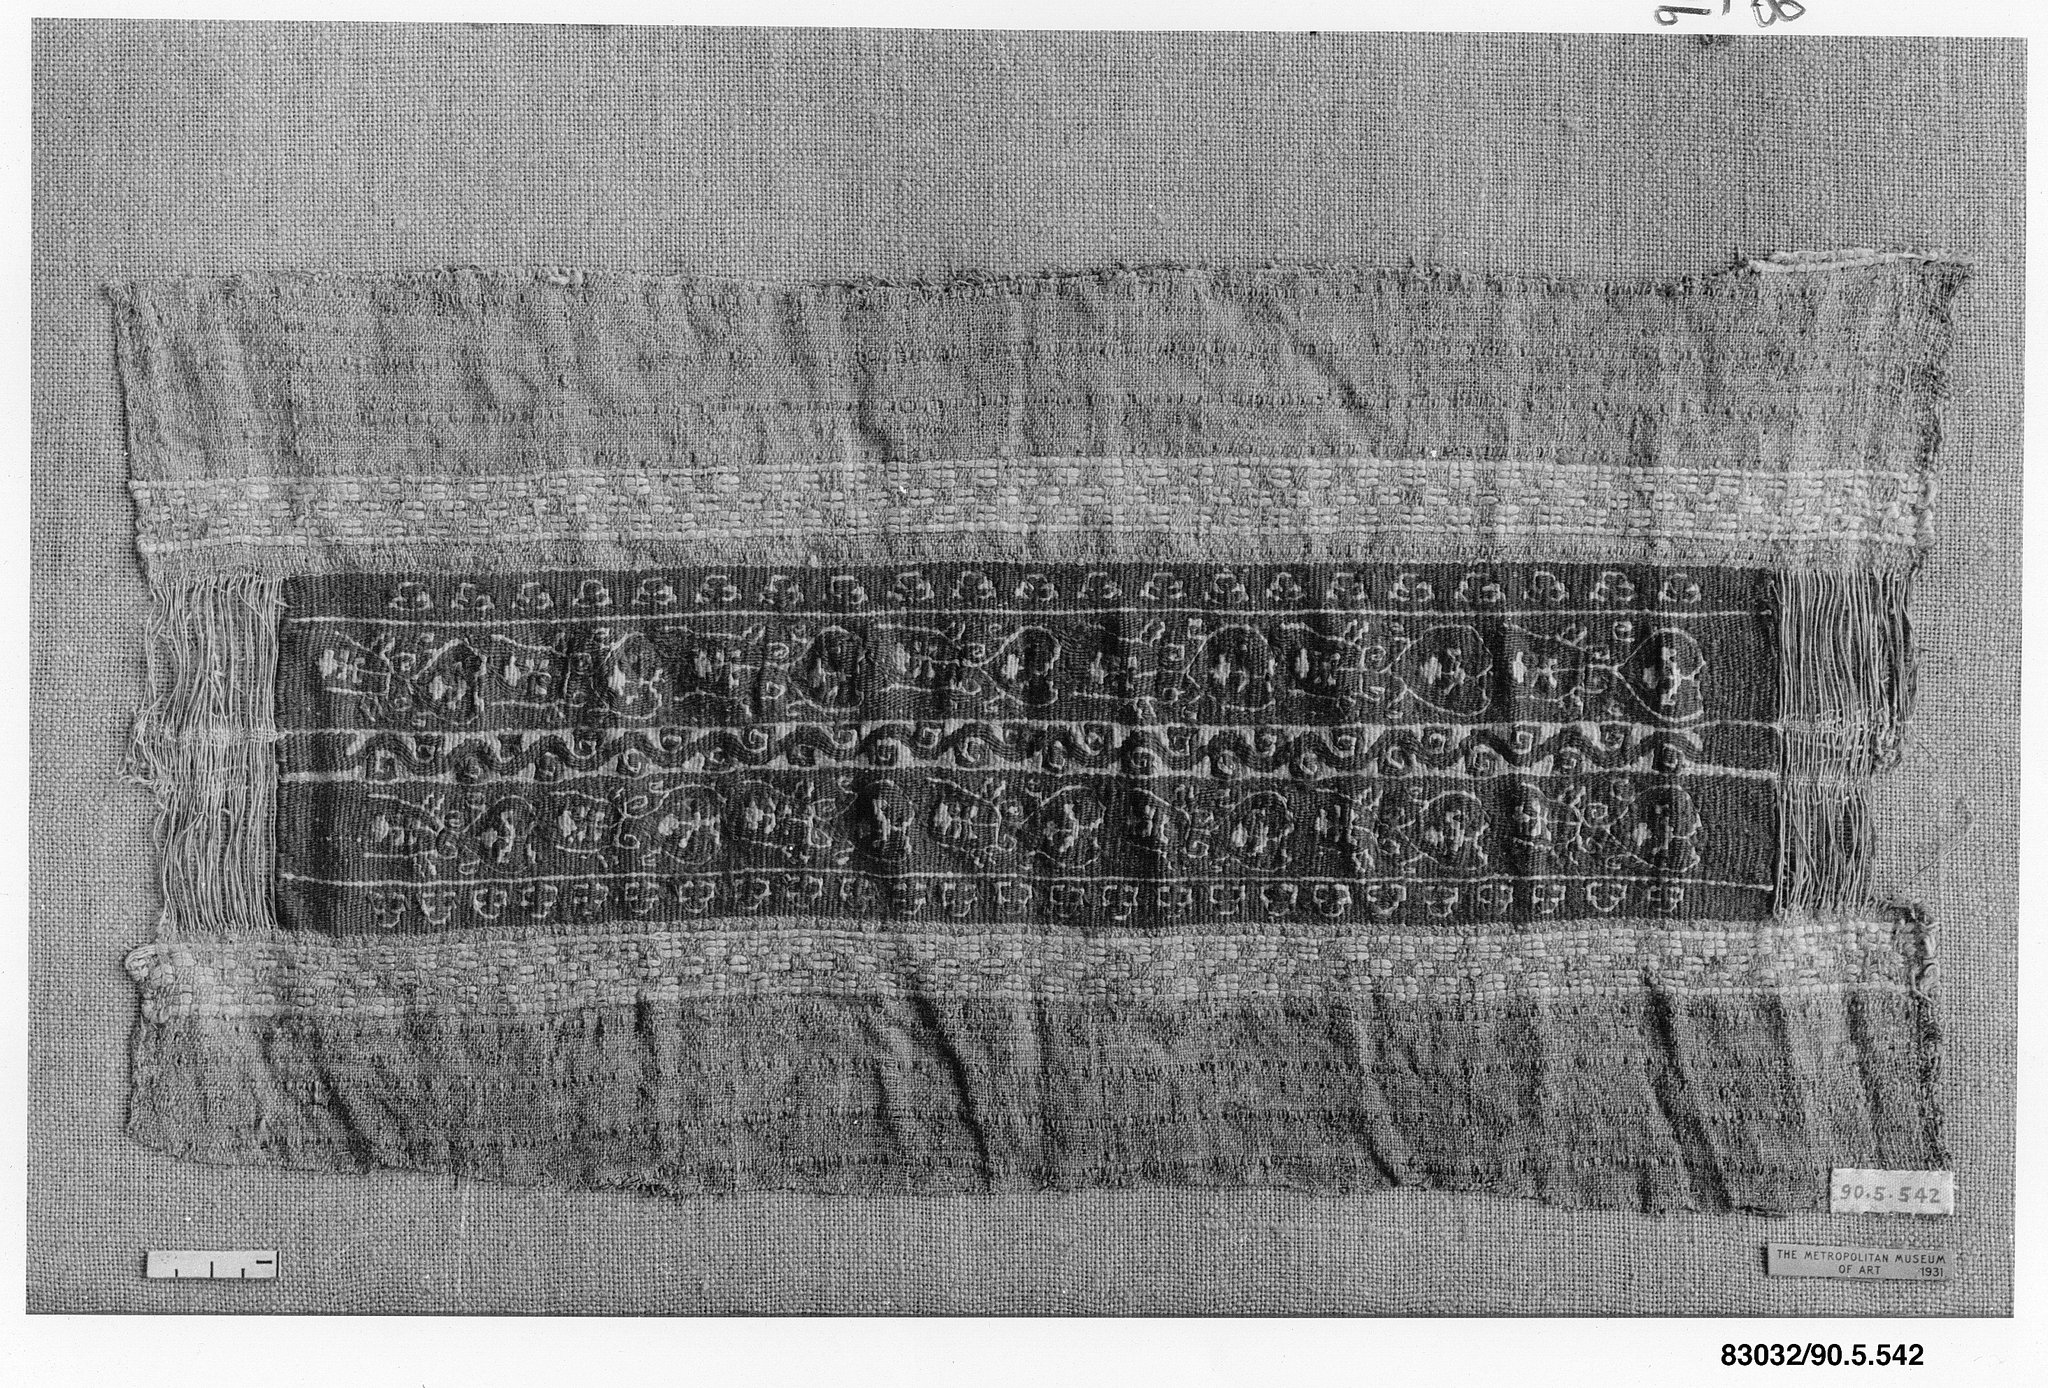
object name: textile fragment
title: Fragment of a Sleeve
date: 301-500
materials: linen, wool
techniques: weave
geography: egypt